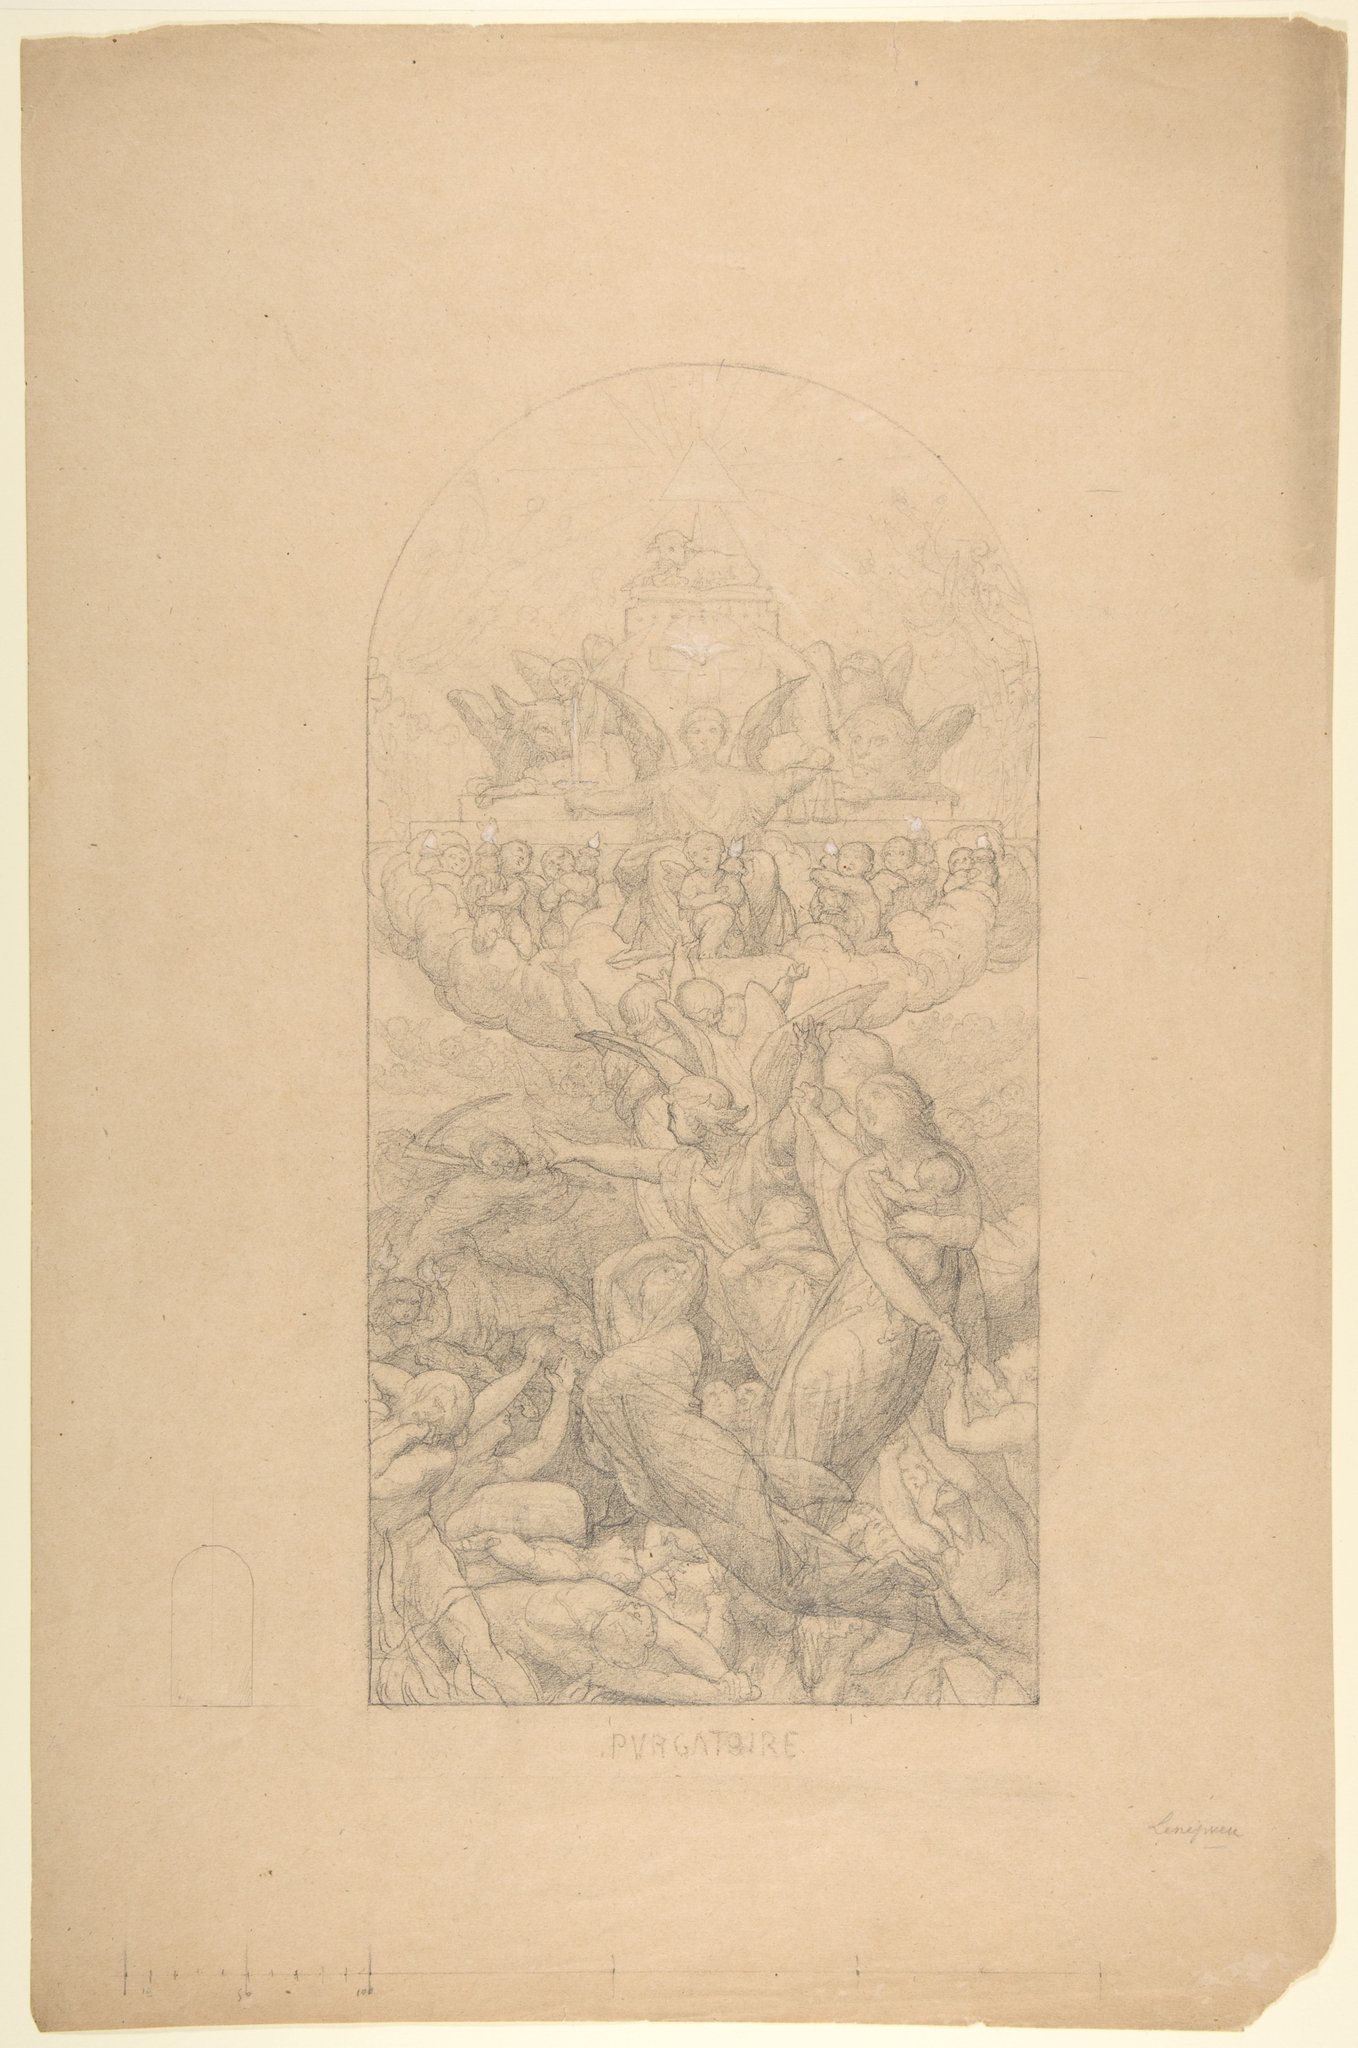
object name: drawing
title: Purgatory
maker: jules-eugène lenepveu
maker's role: artist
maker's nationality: french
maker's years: 1819-1898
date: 1835-1898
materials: graphite, paper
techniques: heightening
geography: france